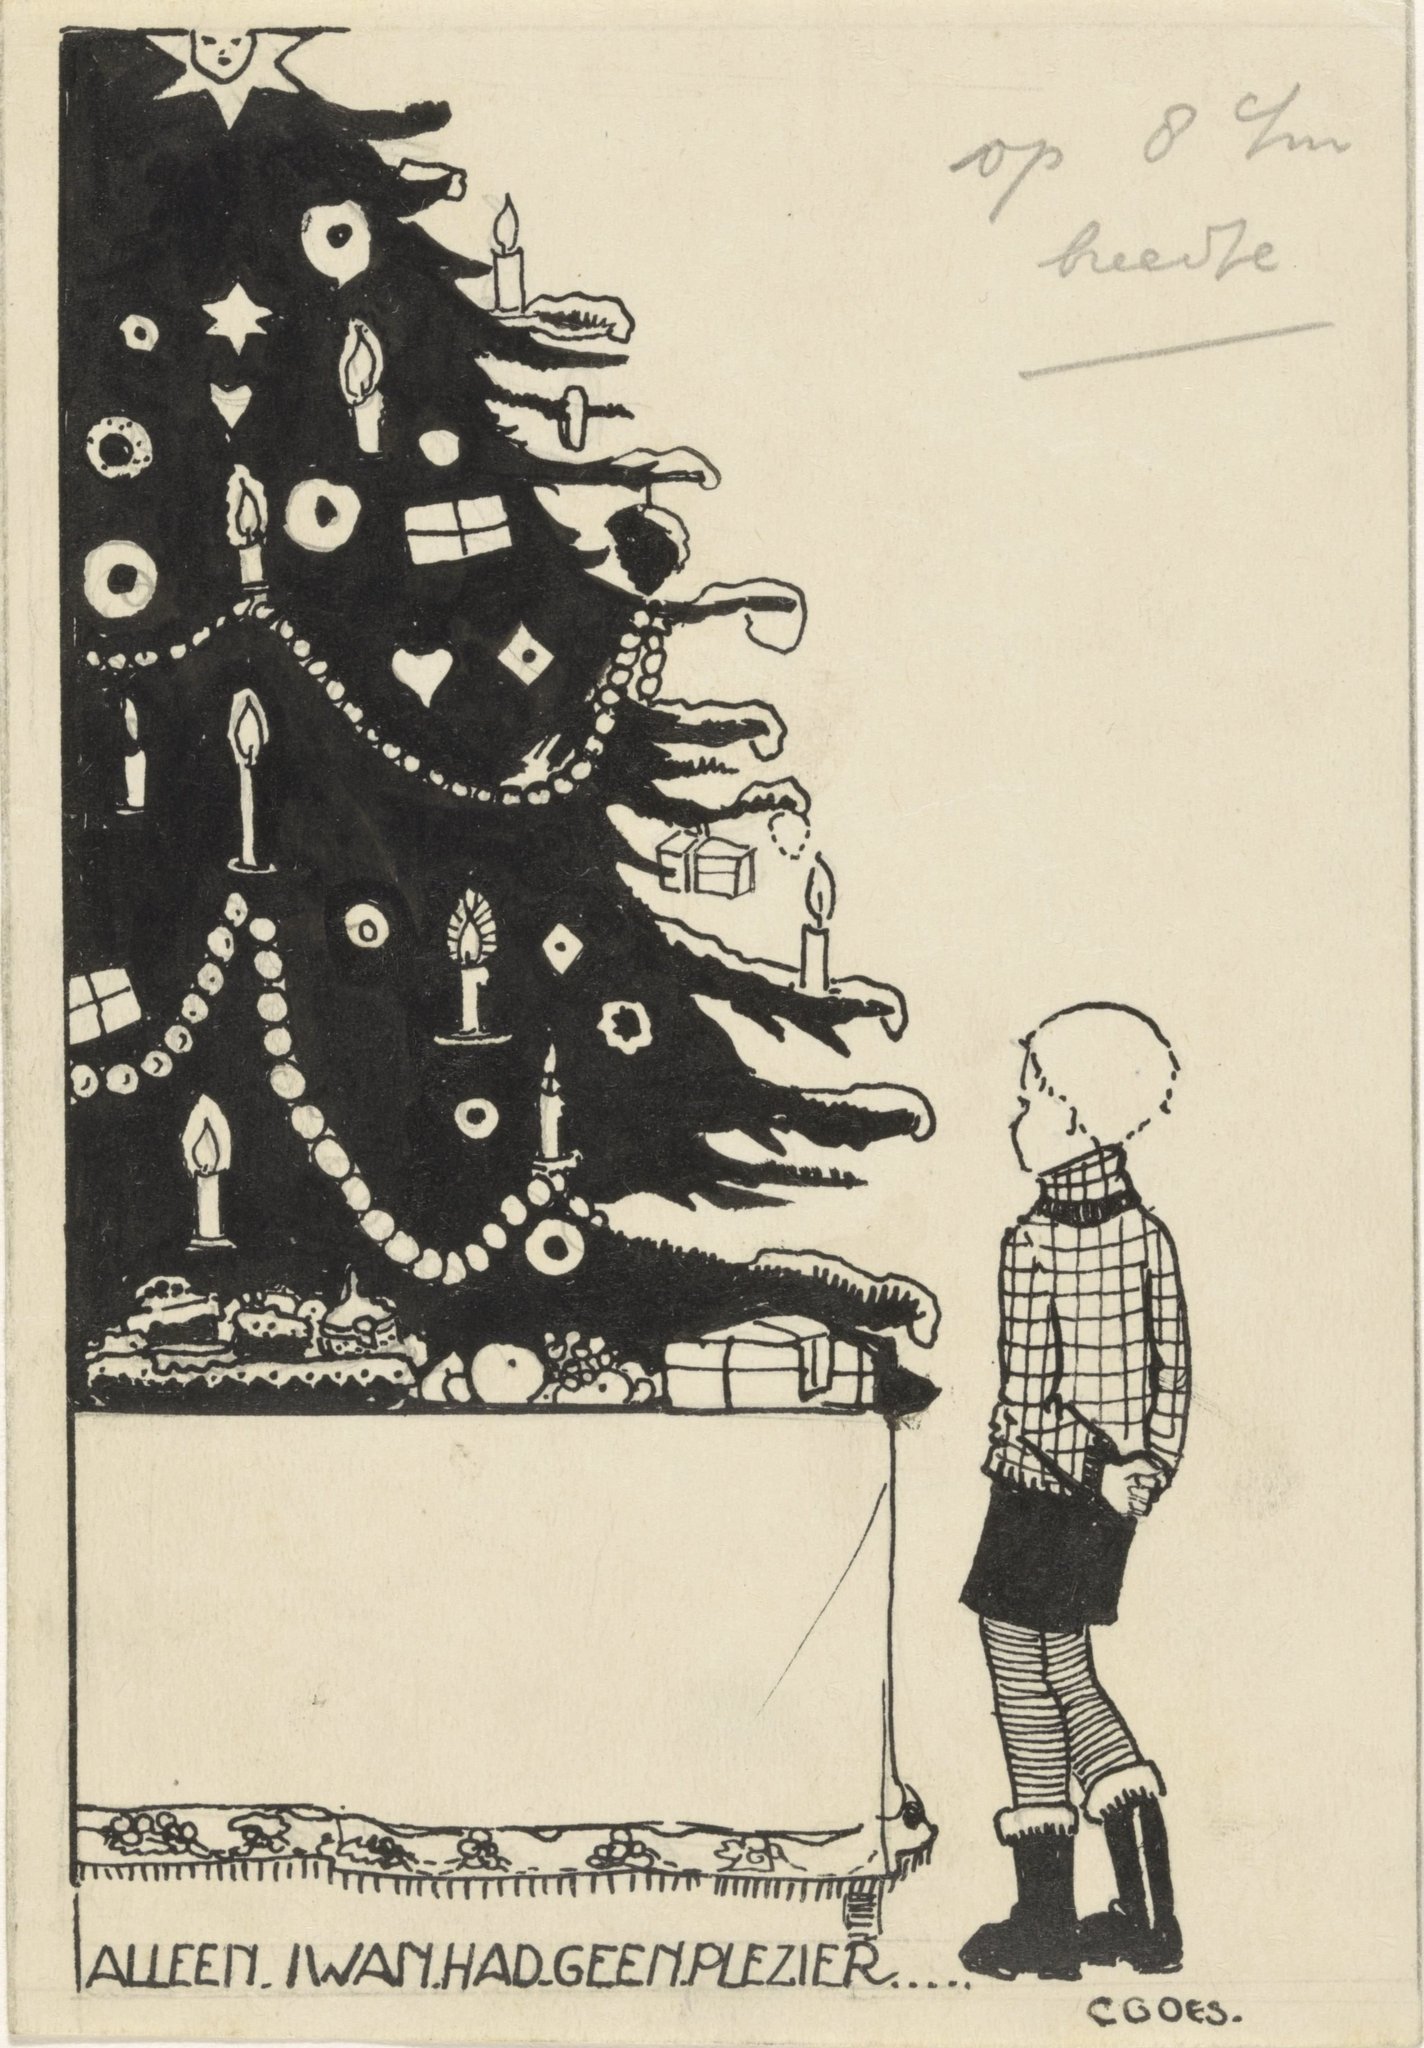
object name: boekillustratie ontwerp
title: Iwan bij een kerstboom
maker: c. goes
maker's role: draughtsman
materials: ink, paper, pencil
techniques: brush, pen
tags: christmas tree, boy (child between toddler and youth), celebration meal, feast, banquet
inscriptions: :, signature: ‘C GOES.’, collector's mark: Lugt 2228a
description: Iwan staat bij een opgetuigde kerstboom. Voor de boom staat een met tafelkleed bedekte tafel waarop schalen met lekkernijen en fruit staan.